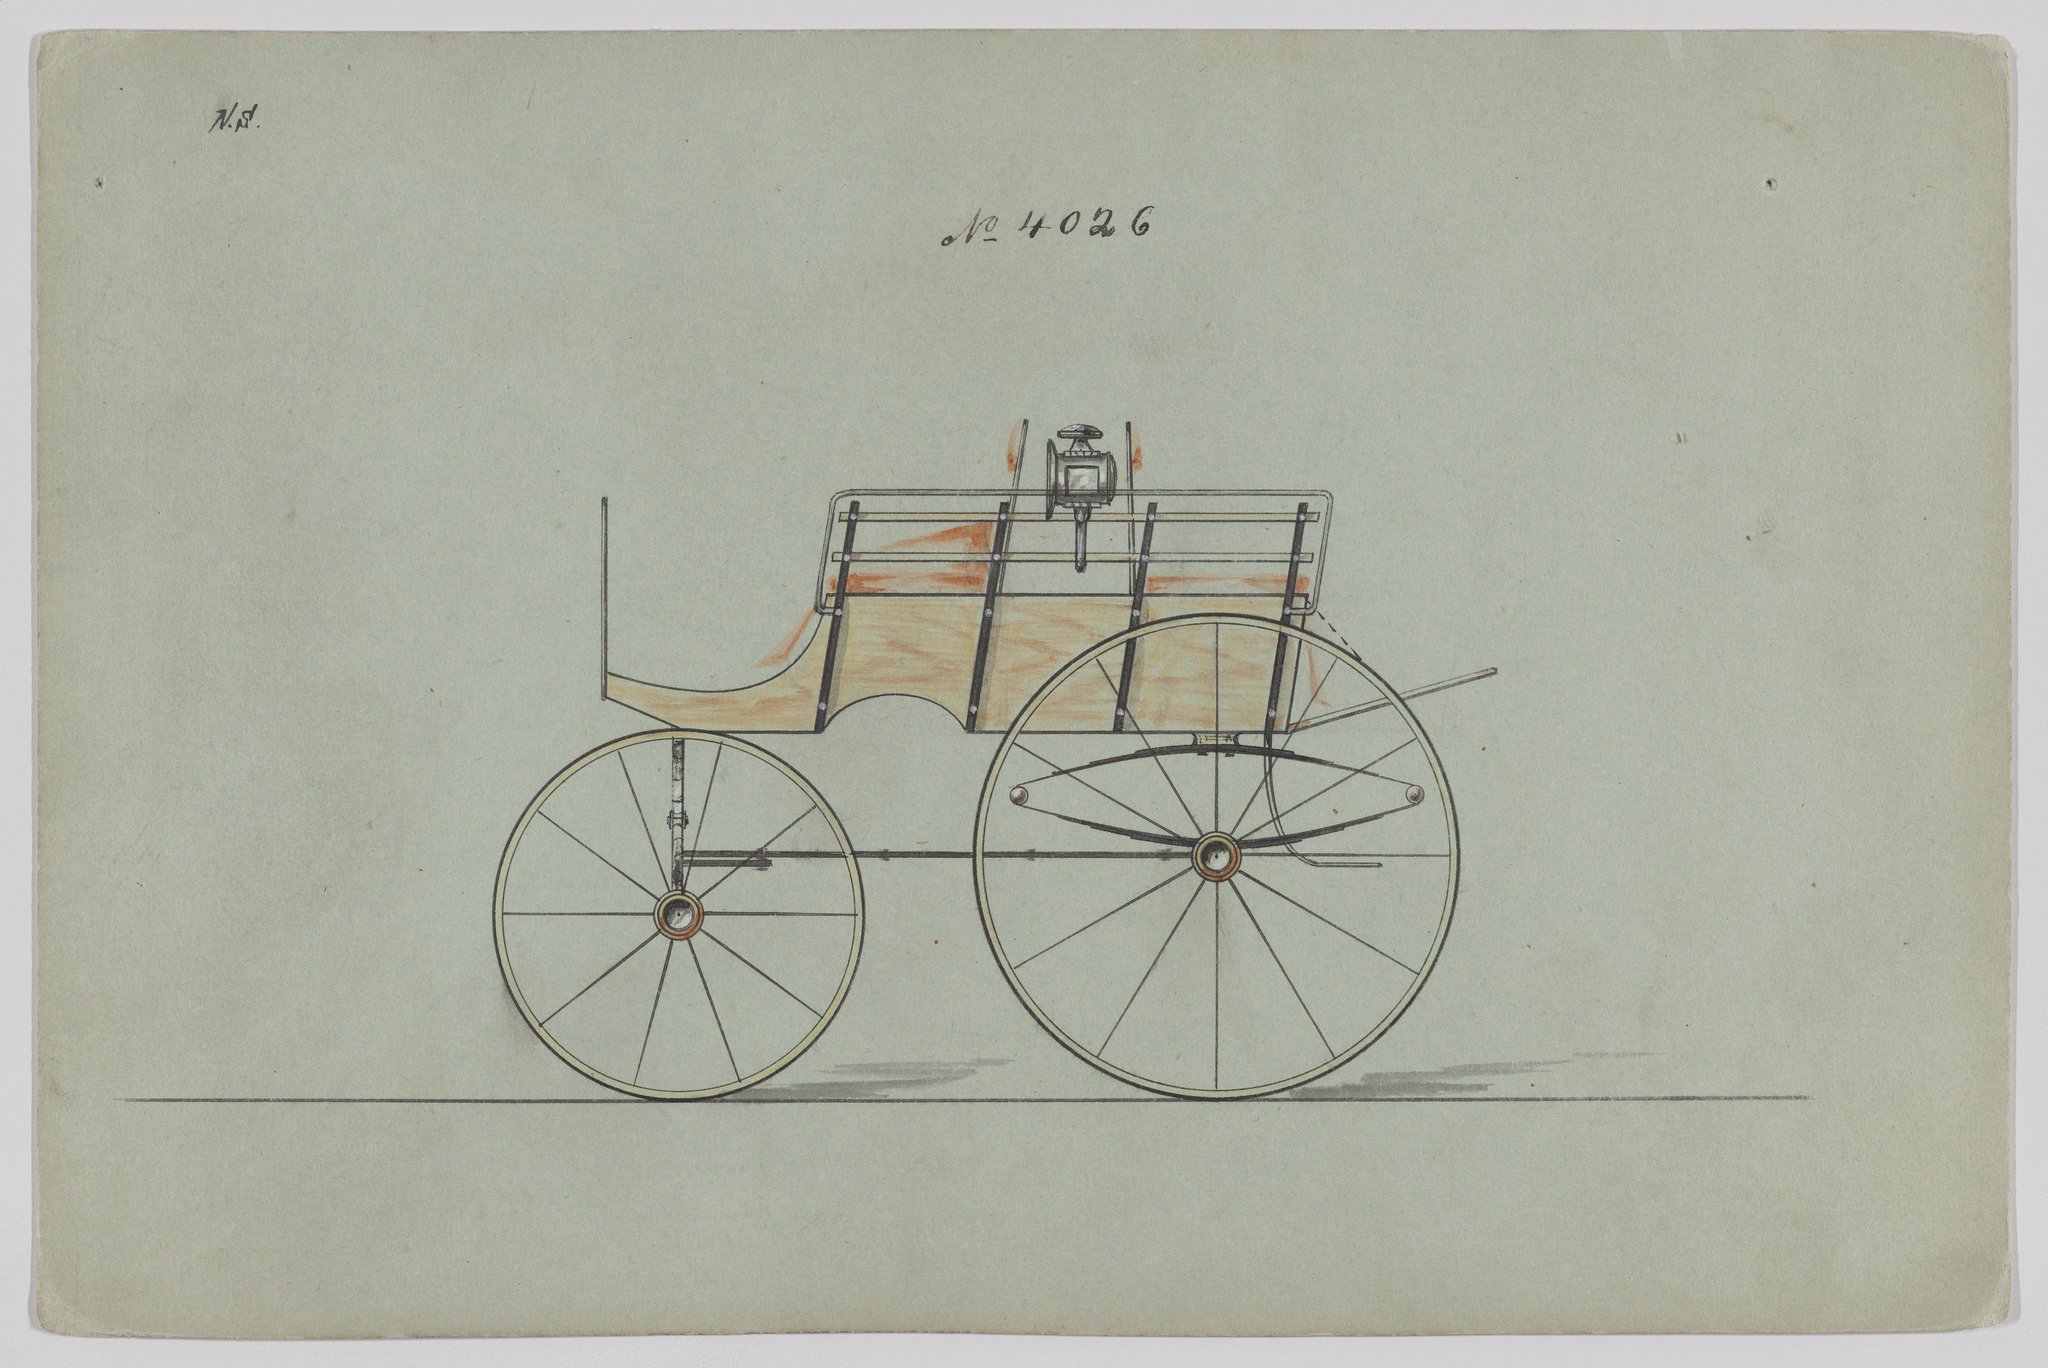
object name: drawing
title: Design for Dos-a-Dos Phaeton, no. 4026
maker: brewster & co.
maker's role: manufacturer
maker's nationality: american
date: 1882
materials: gouache, ink, watercolor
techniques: pen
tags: carriages